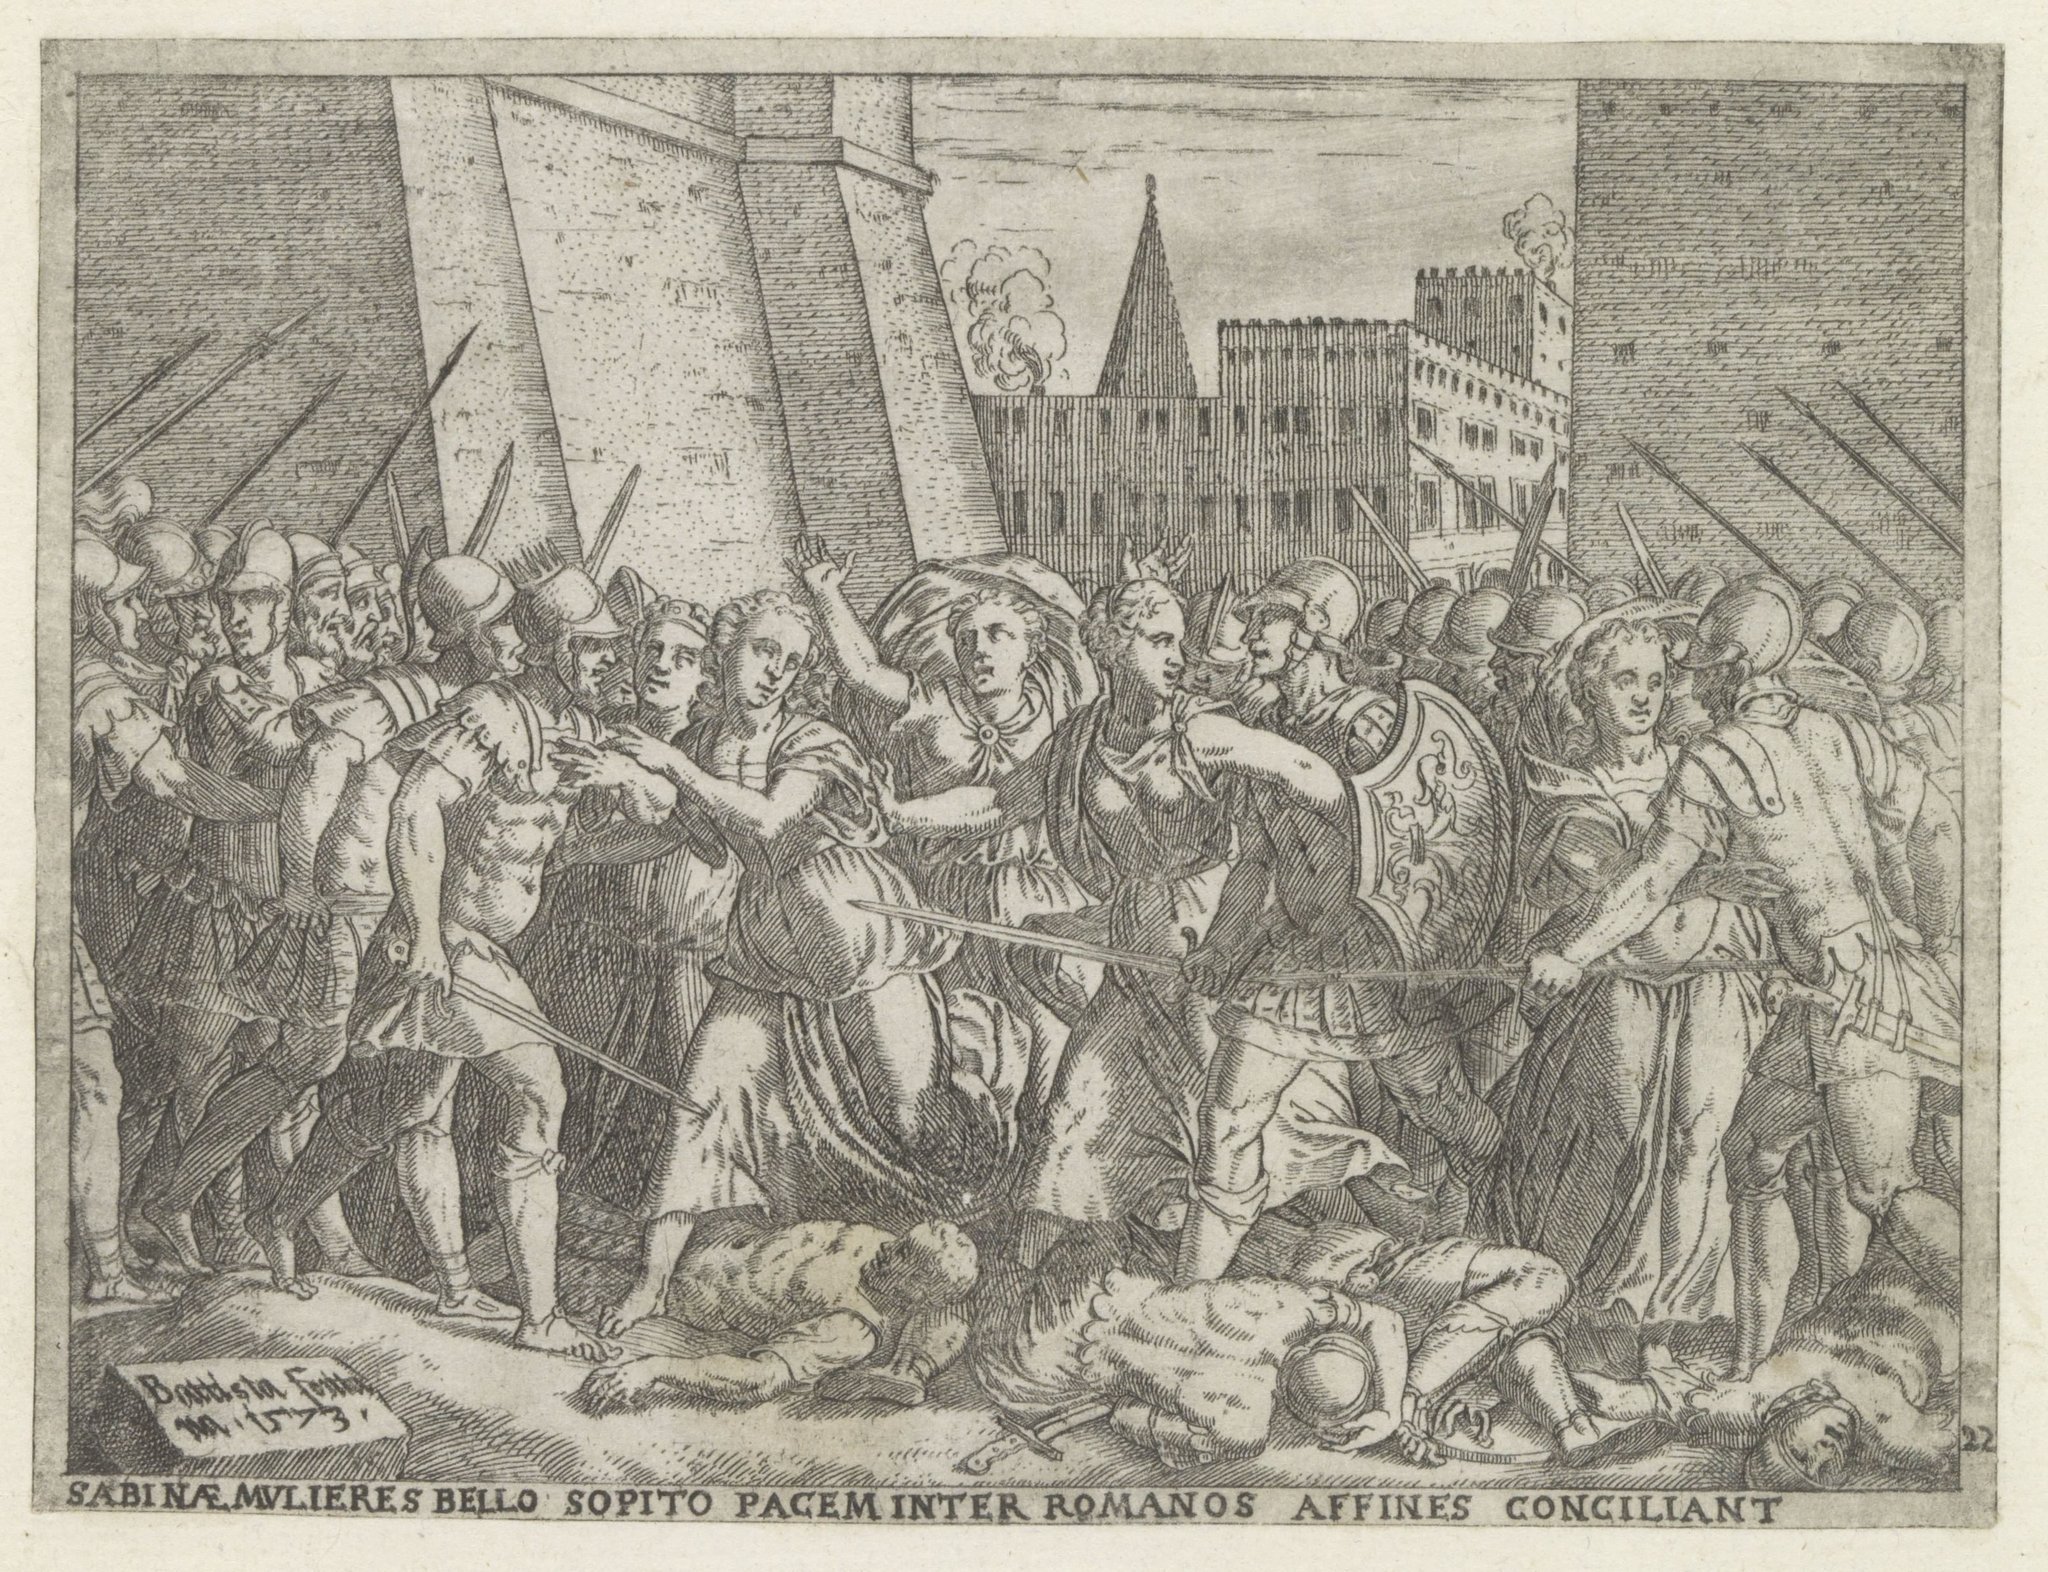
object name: print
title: Sabinea mulieres bello (...) affines conciliant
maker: giovanni battista fontana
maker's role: draughtsman, painter, print maker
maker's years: 1524-1587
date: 1573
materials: paper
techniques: etching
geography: italy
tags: (story of) romulus and remus, reconciliation of the sabines and the romans: the women, some holding their babies, others with their hair loose, and possibly encouraged by hersilia call for peace in the midst of the two fighting armies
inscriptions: date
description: De moeders van de Sabijnse maagden werpen zich tussen de twee vechtende legers van Sabijnen en Romeinen en doen een oproep tot vrede. De prent maakt deel uit van een album.